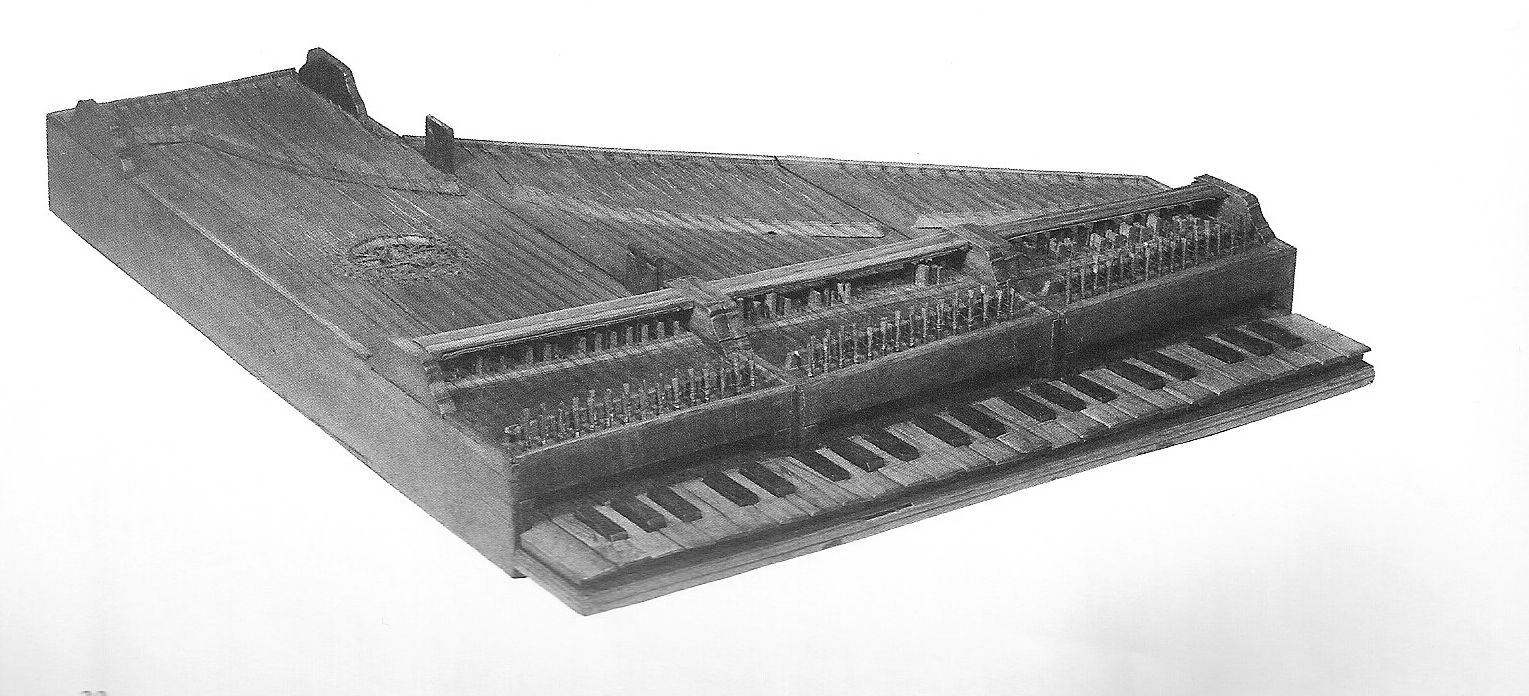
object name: folding harpsichord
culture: italian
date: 1734-1766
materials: wood, iron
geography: italy